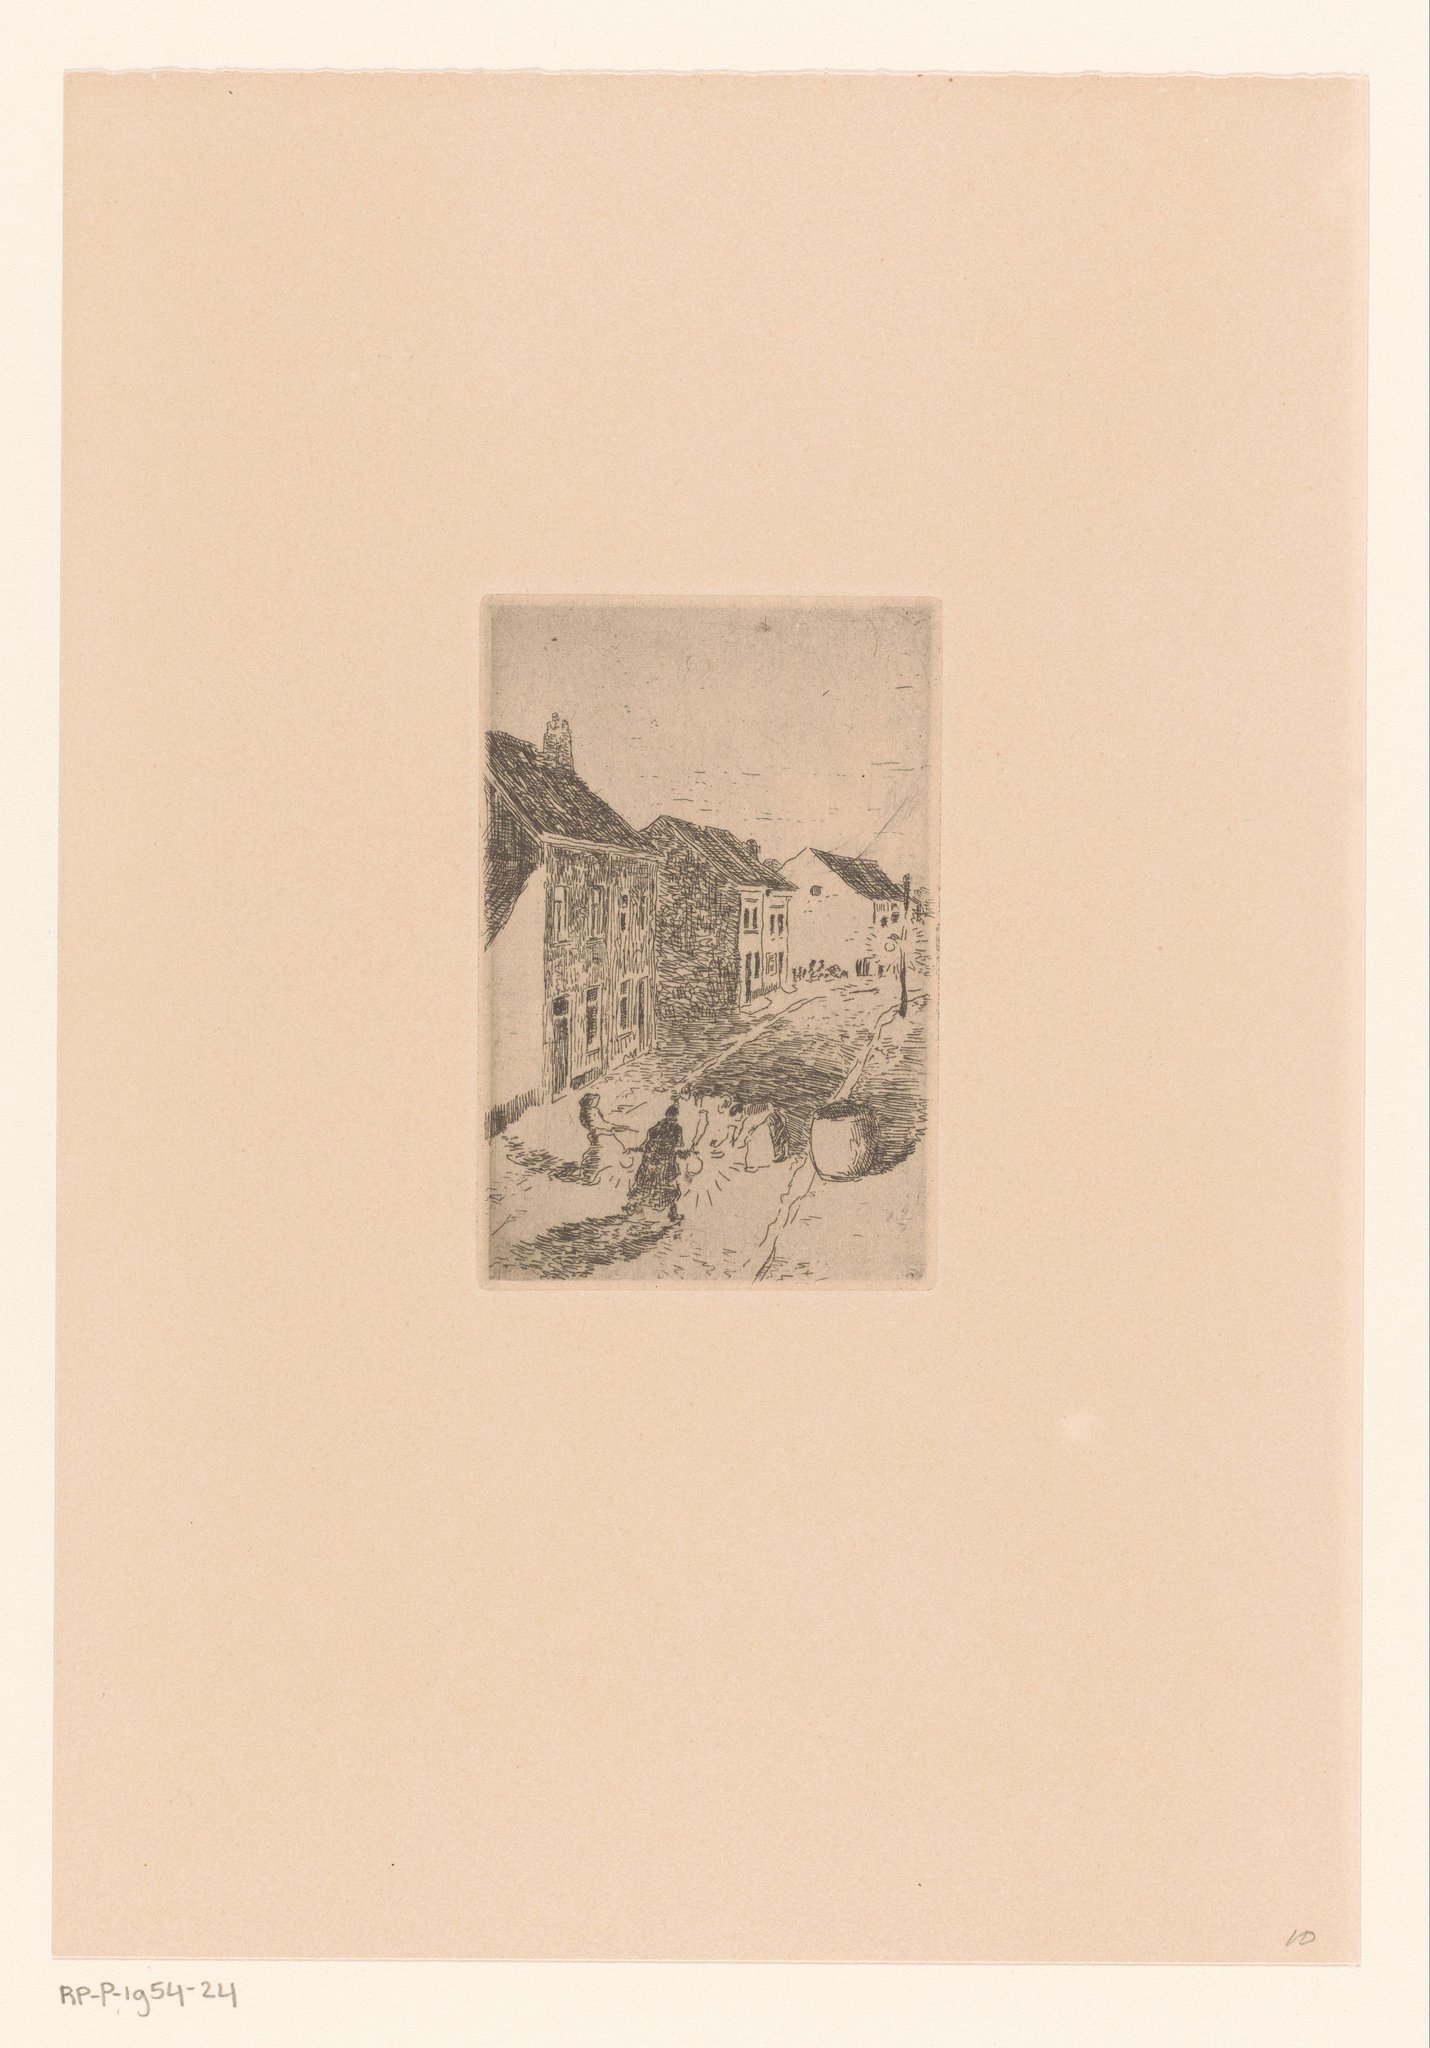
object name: print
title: Vrouwen met lantaarns op straat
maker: rik wouters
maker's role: draughtsman, print maker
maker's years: 1882-1916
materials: paper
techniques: etching, intaglio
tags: village street, lantern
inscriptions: collector's mark: Lugt 2228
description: Op een voorbereidende tekening voor deze prent staat een opmerking dat het hier om het branden van een varken gaat: "On brule le cochon dans la rue".